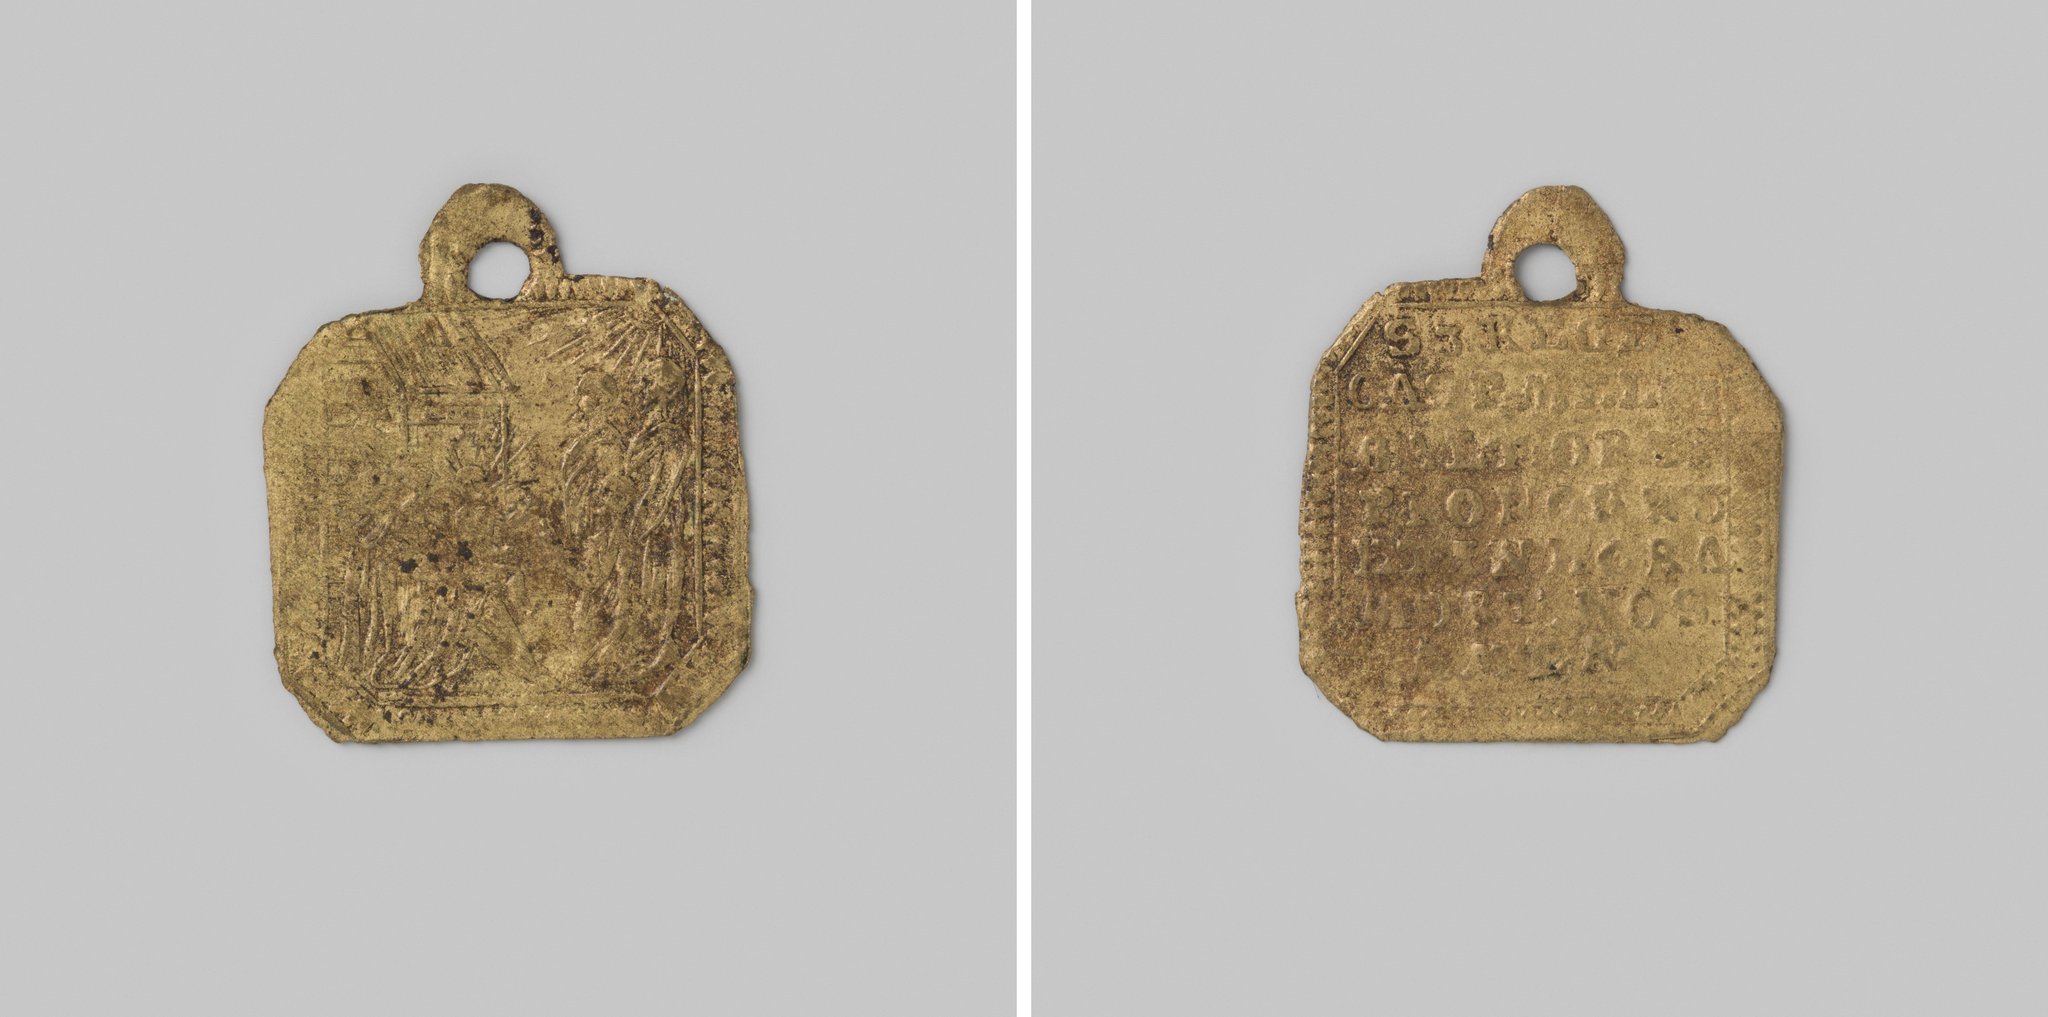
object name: history medal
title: Religieus draagteken Driekoningen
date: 1700-1850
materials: brass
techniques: striking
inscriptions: inscription: ‘S 3 REGE / CASP MELCH/ BALT ORAT / PRO NOB NO / ETEN HORA / MORT NOS / AMEN’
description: Rechthoekig penninkje van messingblik met draagoog, op de voorzijde de aanbidding der wijzen, op de keerzijde zeven regels tekst.